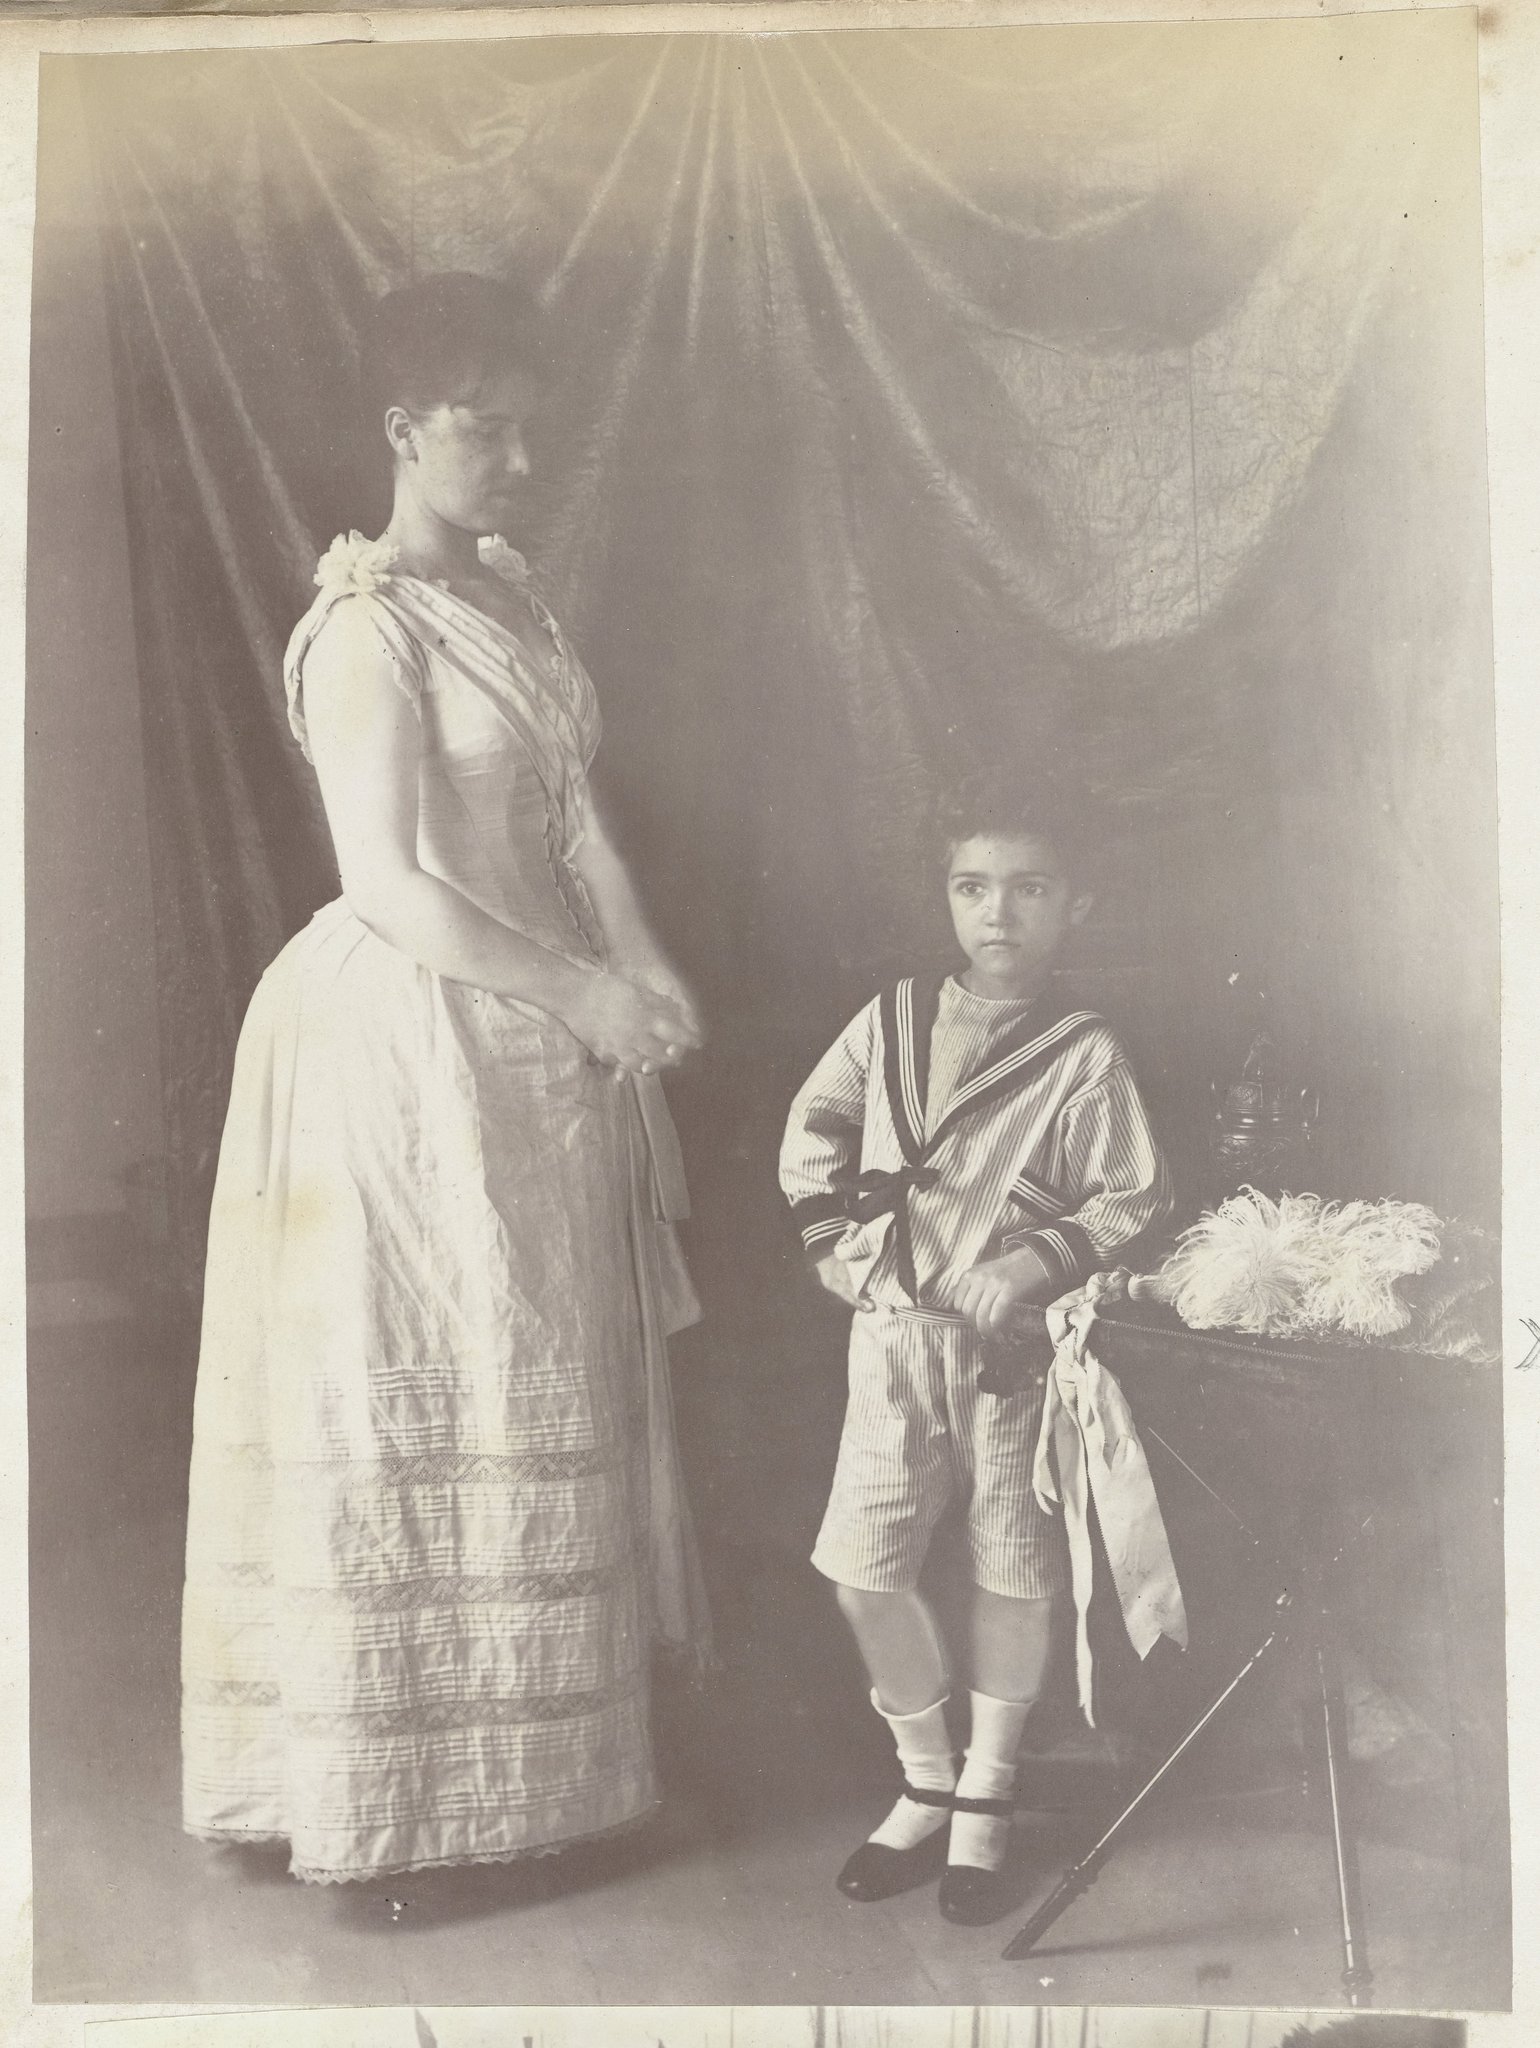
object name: photograph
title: Portret van een vrouw en een jongen in een fotostudio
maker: Anonymous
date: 1879-1890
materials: paper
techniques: albumen print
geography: china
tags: ensemble of pieces of clothing: sailor suit, boy (child between toddler and youth), historical persons not known by name, china